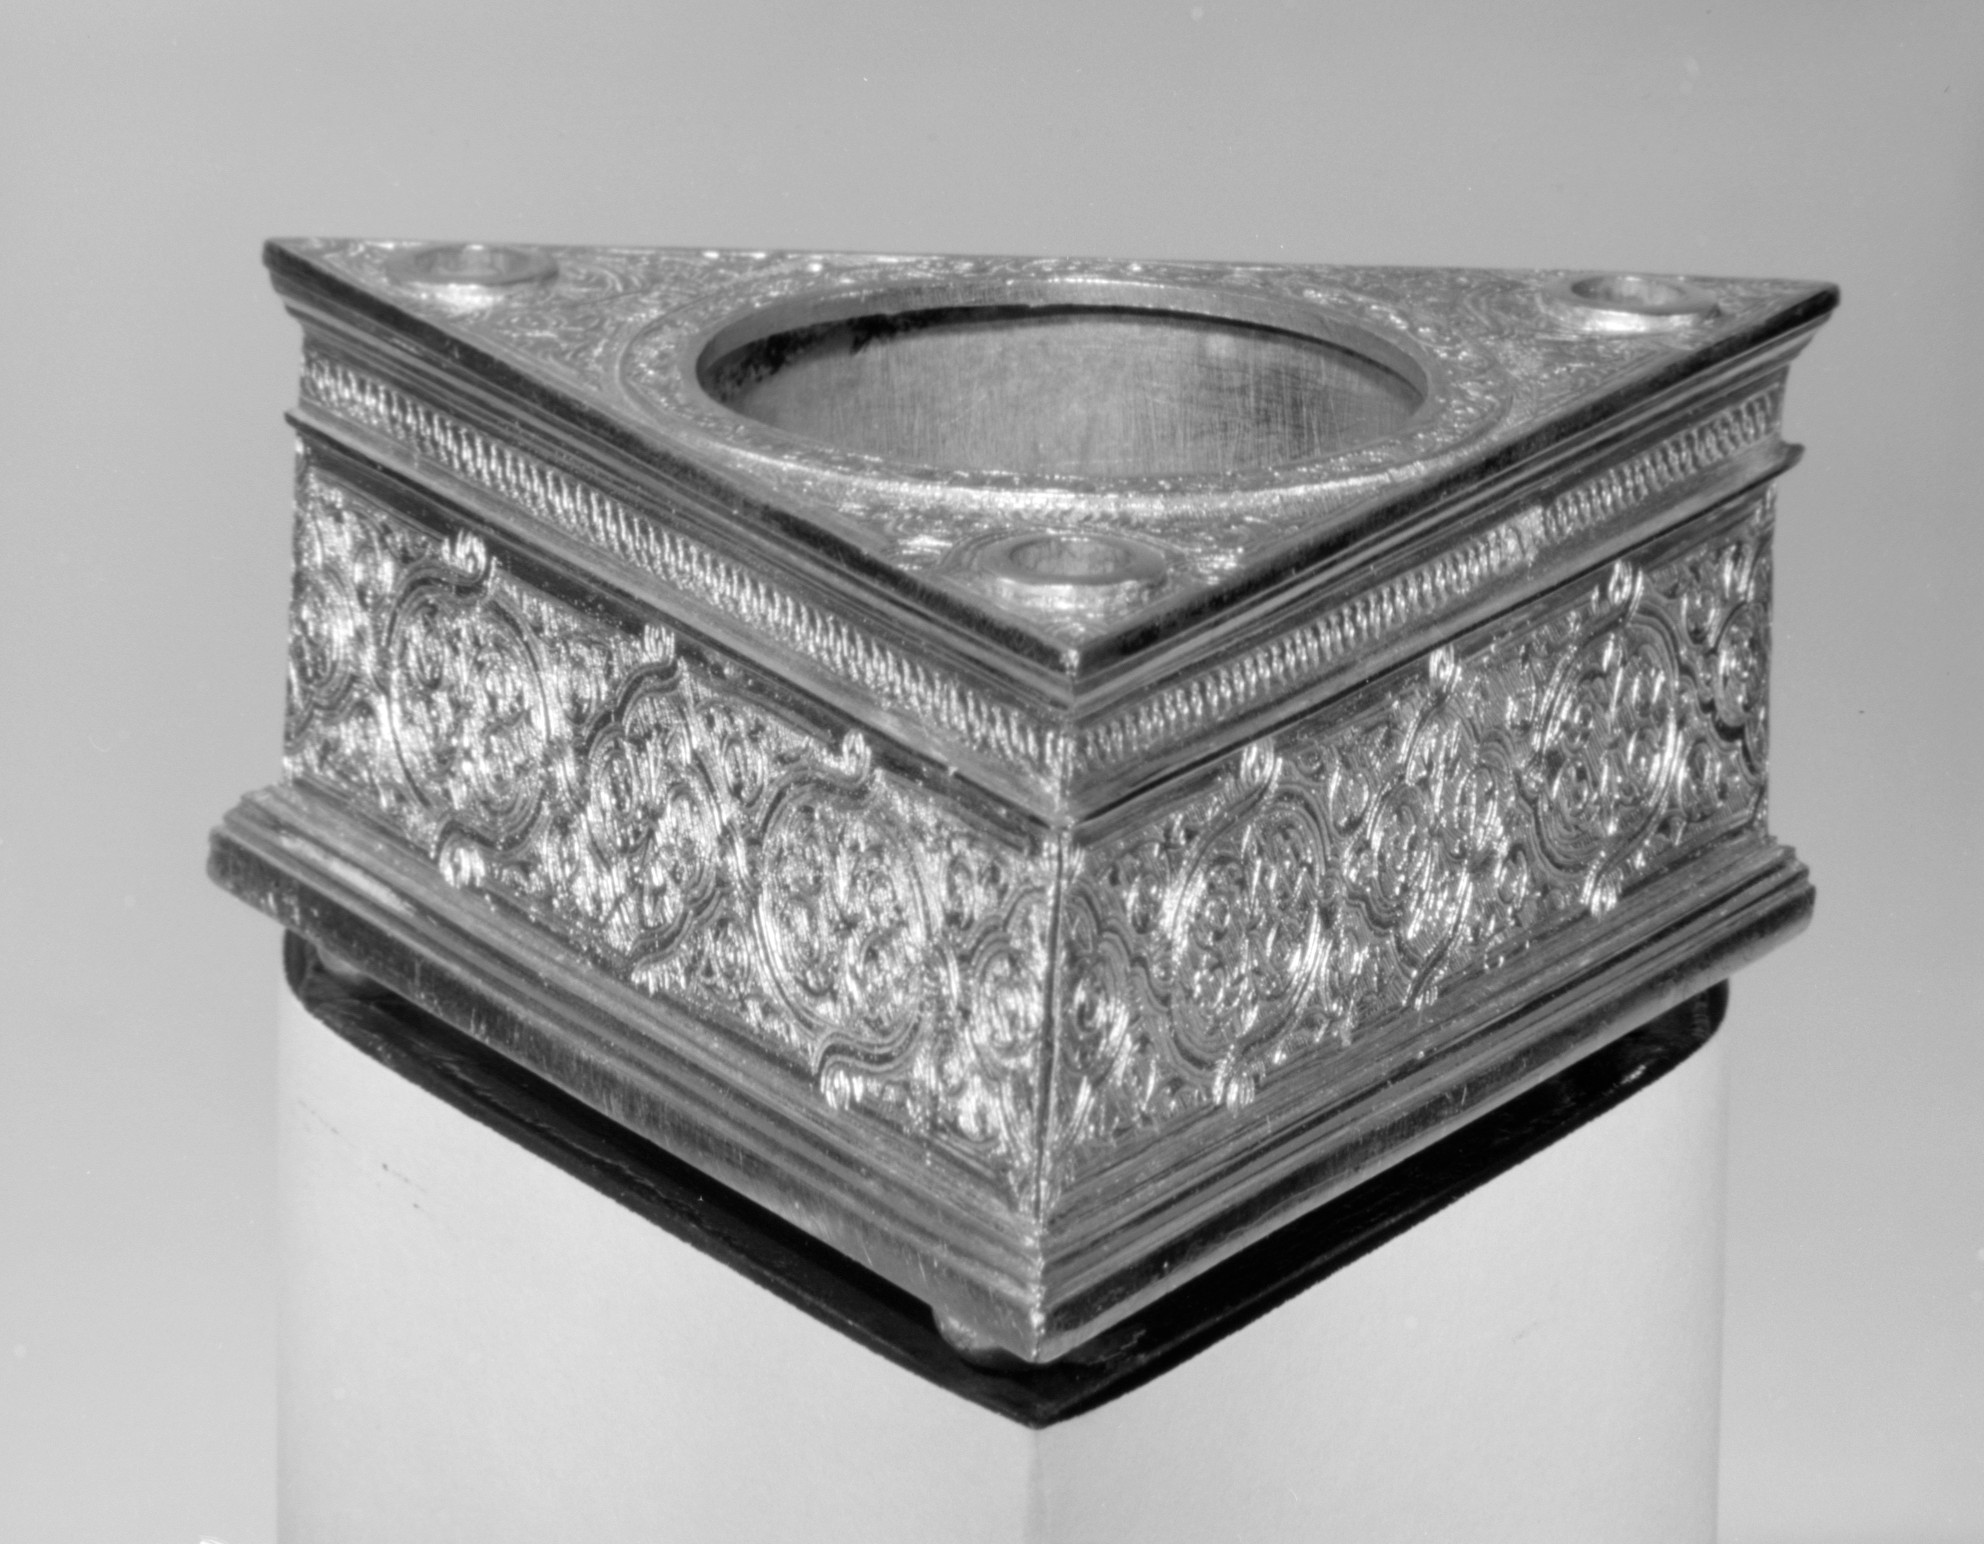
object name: inkstand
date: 1801-1900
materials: silver gilt